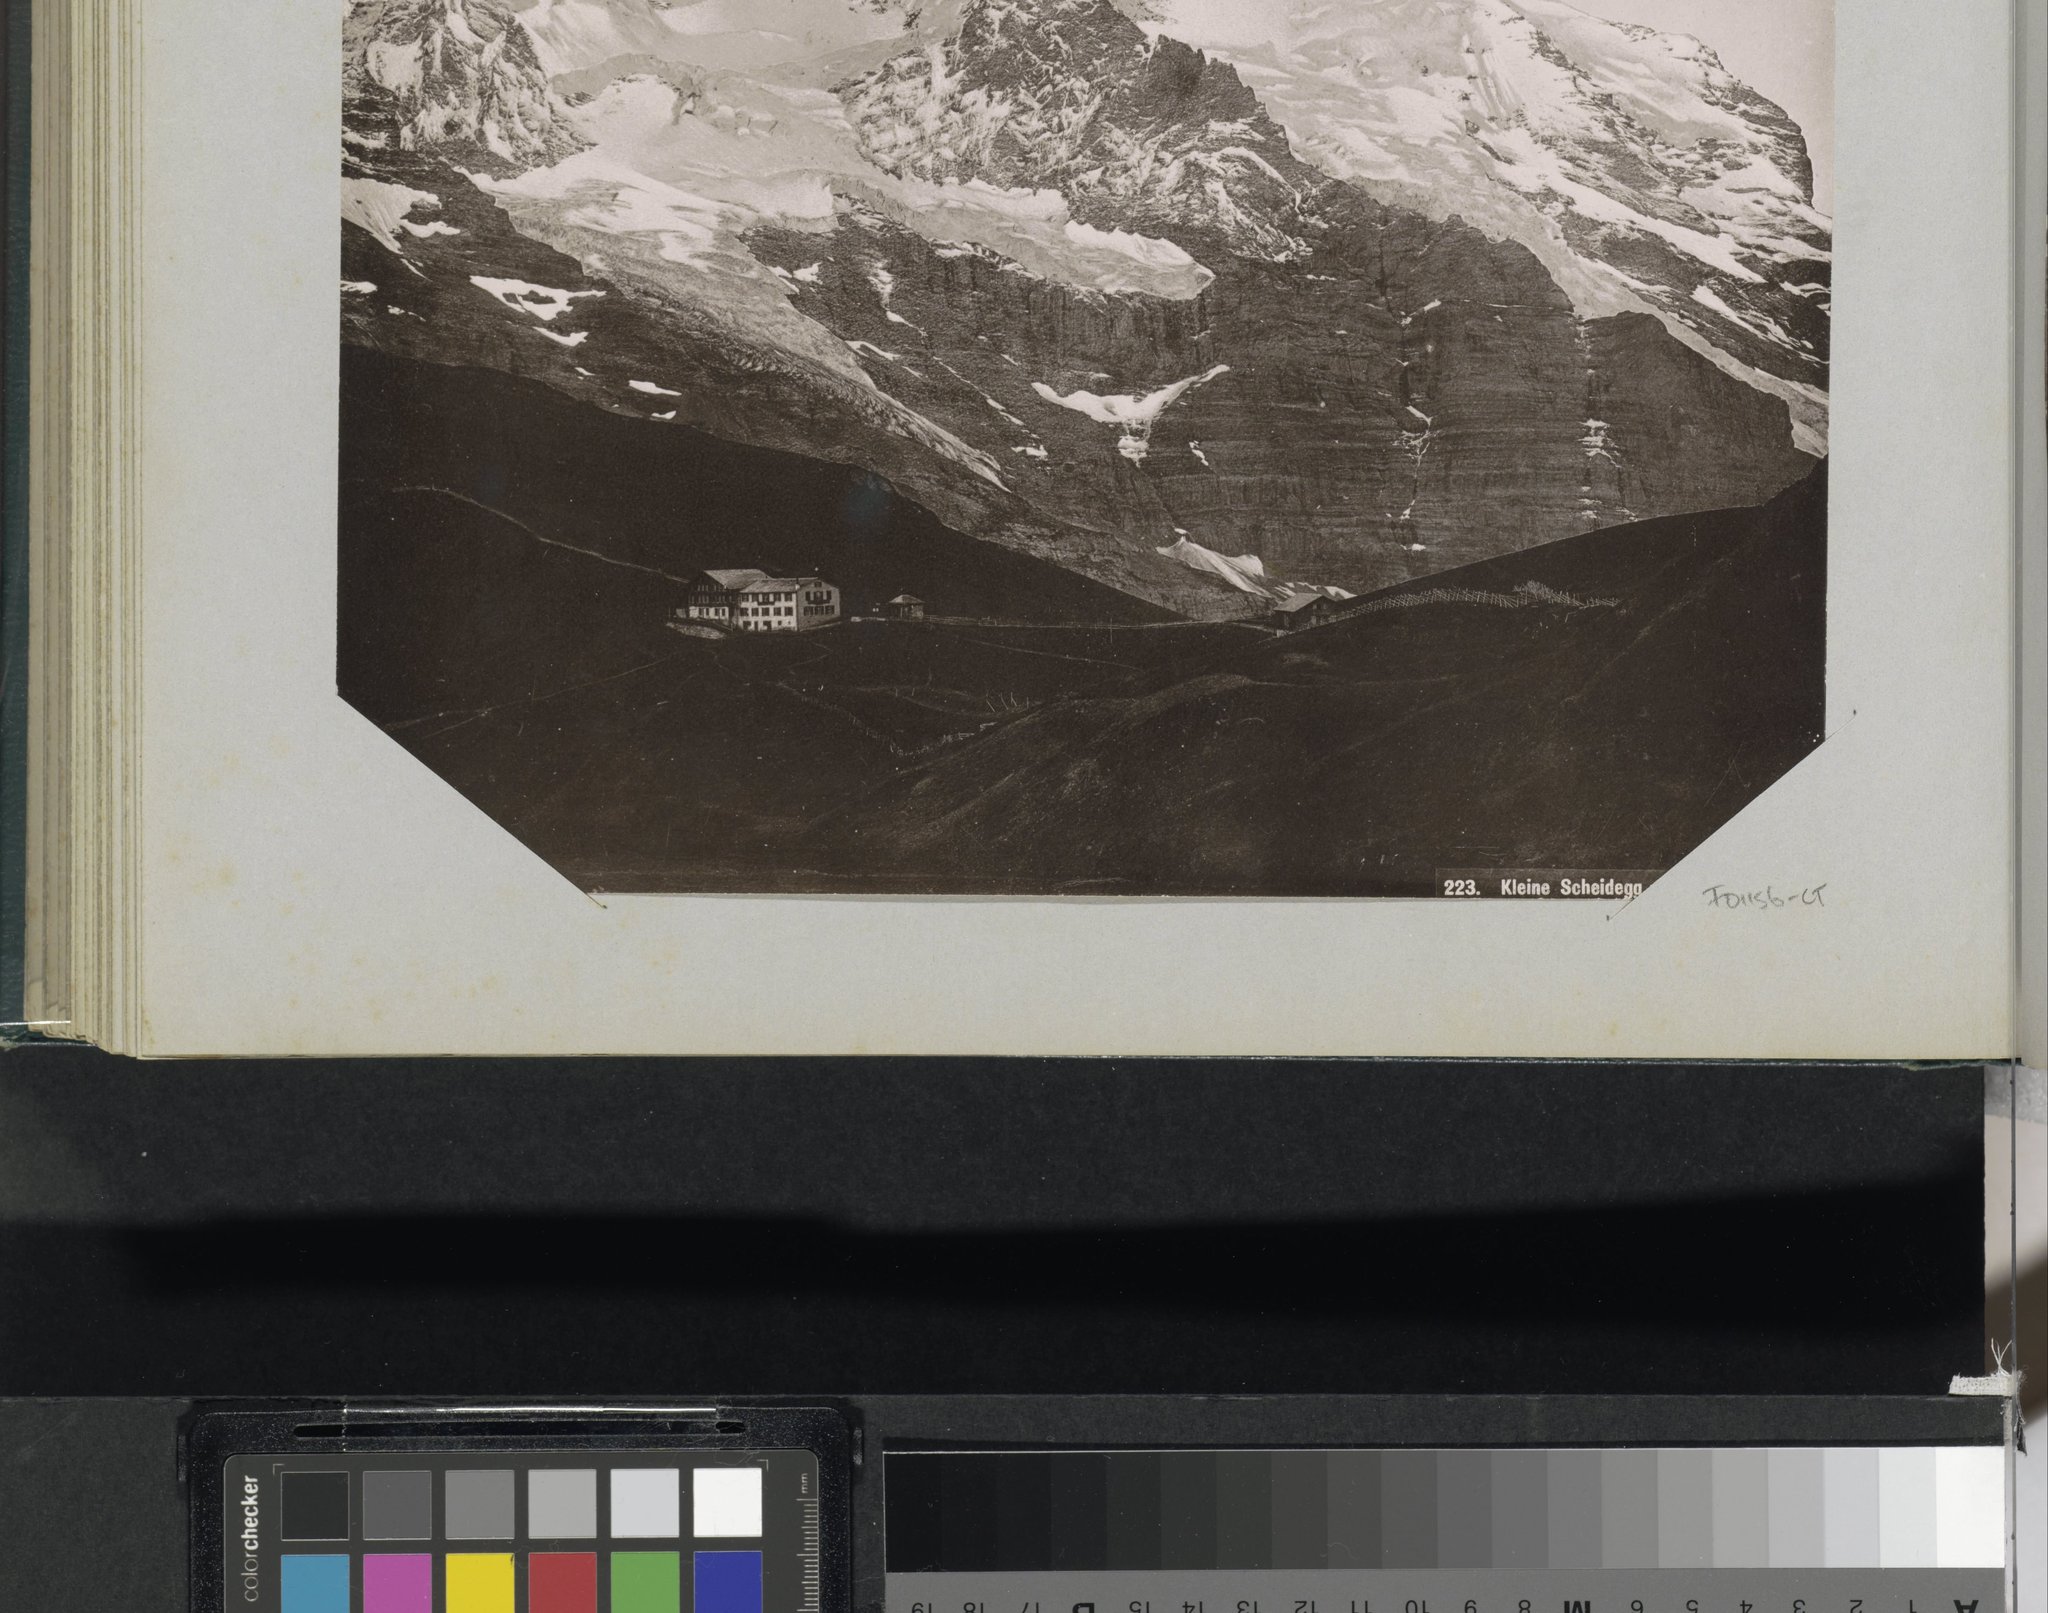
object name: photomechanical print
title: Gezicht op de Kleine Scheidegg en de Jungfrau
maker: Anonymous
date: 1896-1897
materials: paper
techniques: photograph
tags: mountain-range, snow peaks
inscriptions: inscription: ‘223. Kleine Scheidegg (Jungfrau)’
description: Deze prent maakt deel uit van een album.